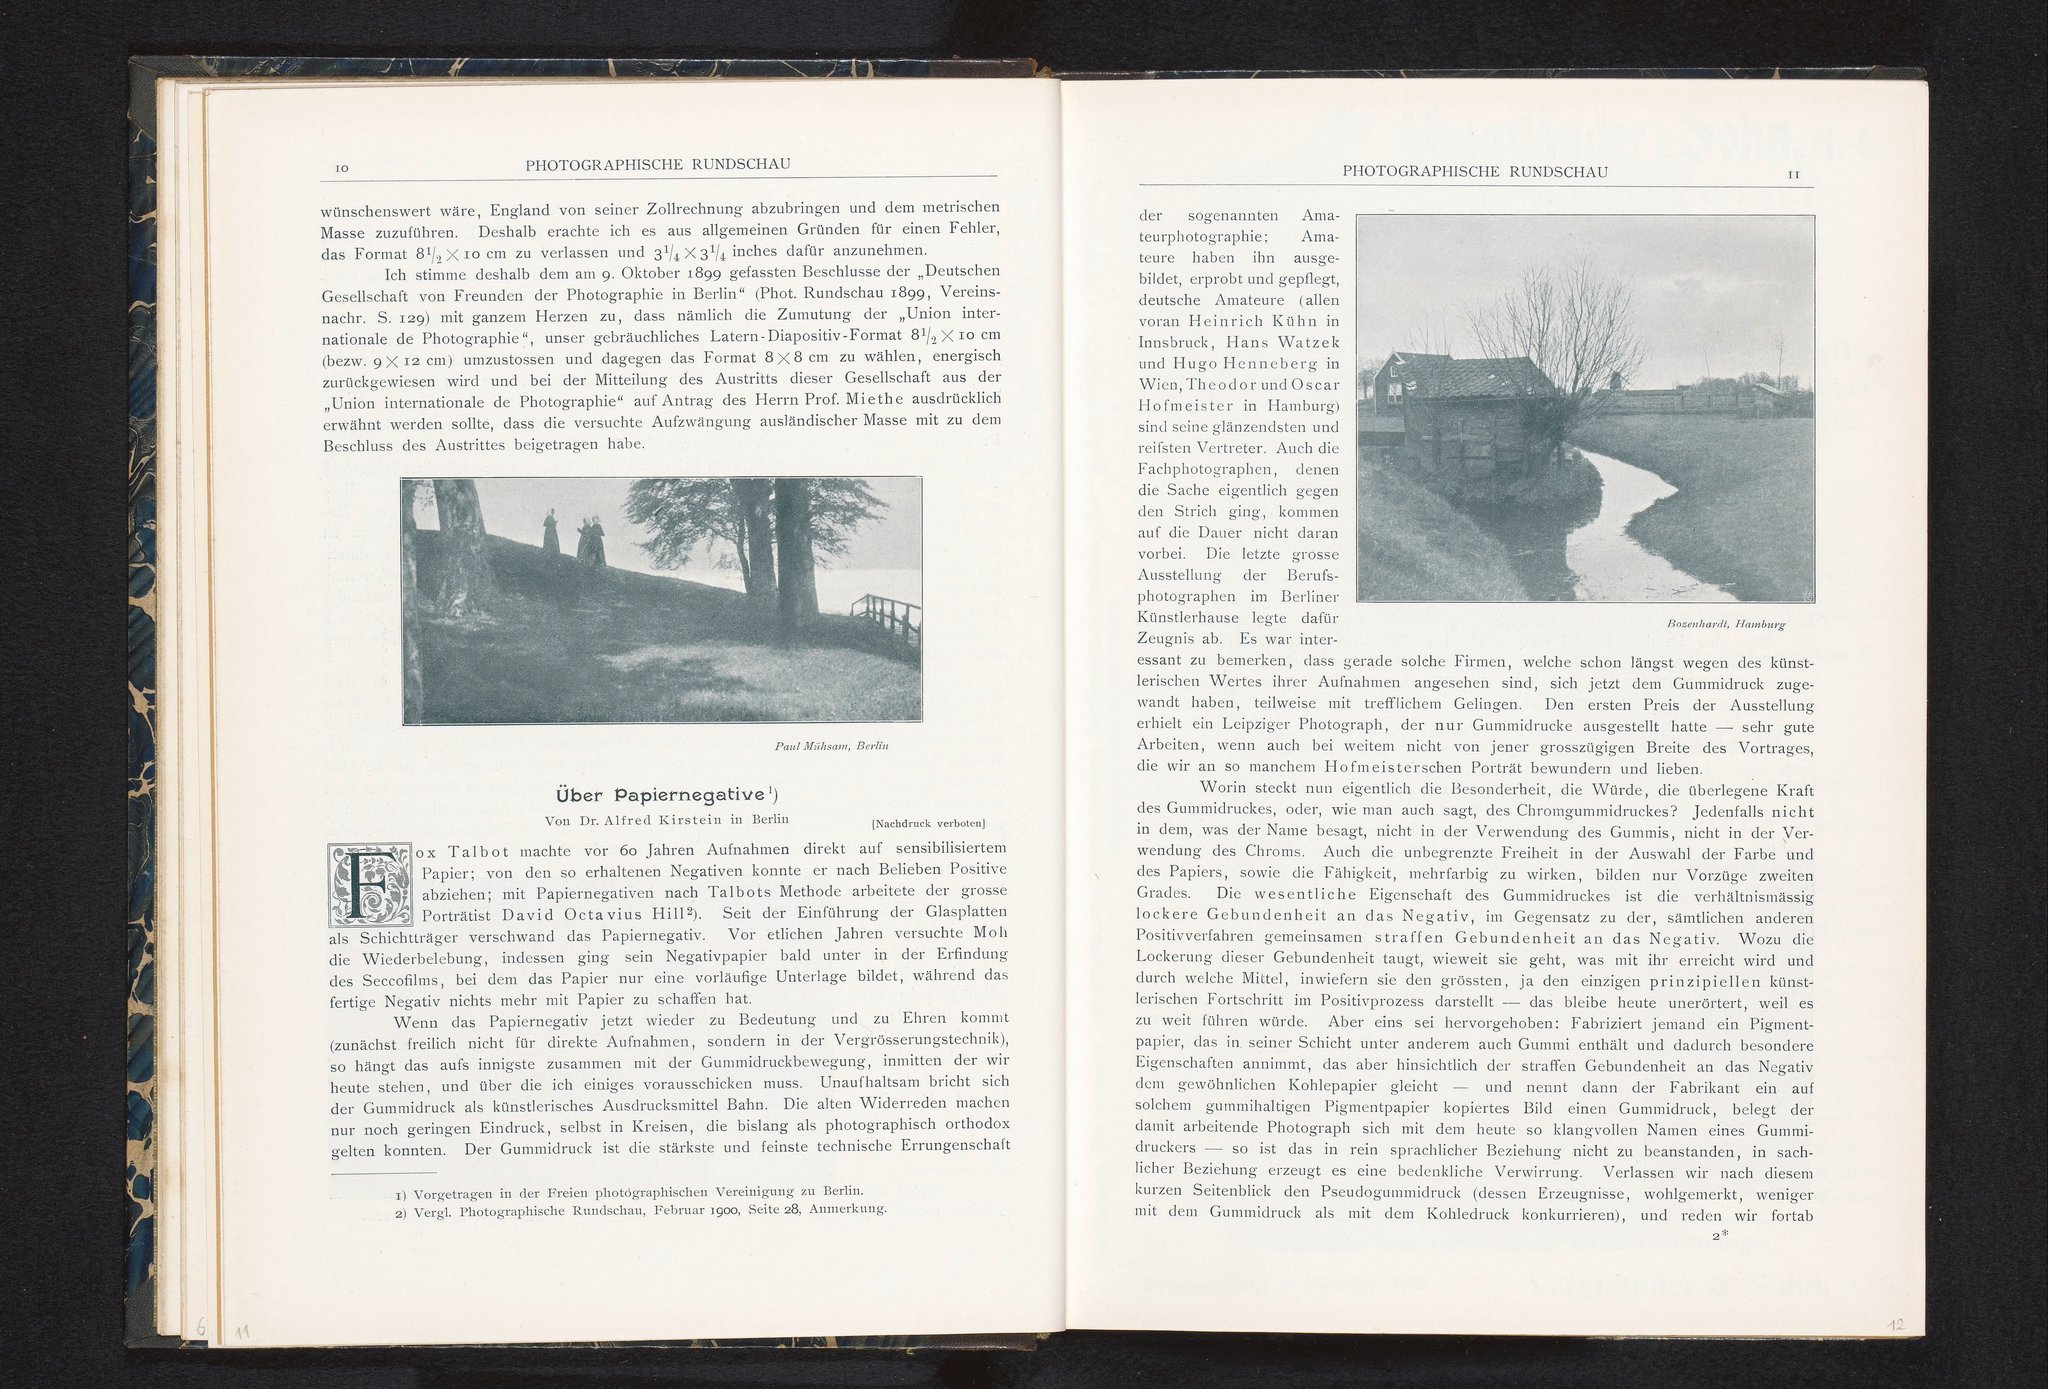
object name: photomechanical print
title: Drie vrouwen op een heuvel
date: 1896-1901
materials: paper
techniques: autotype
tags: adult woman, (high) hill